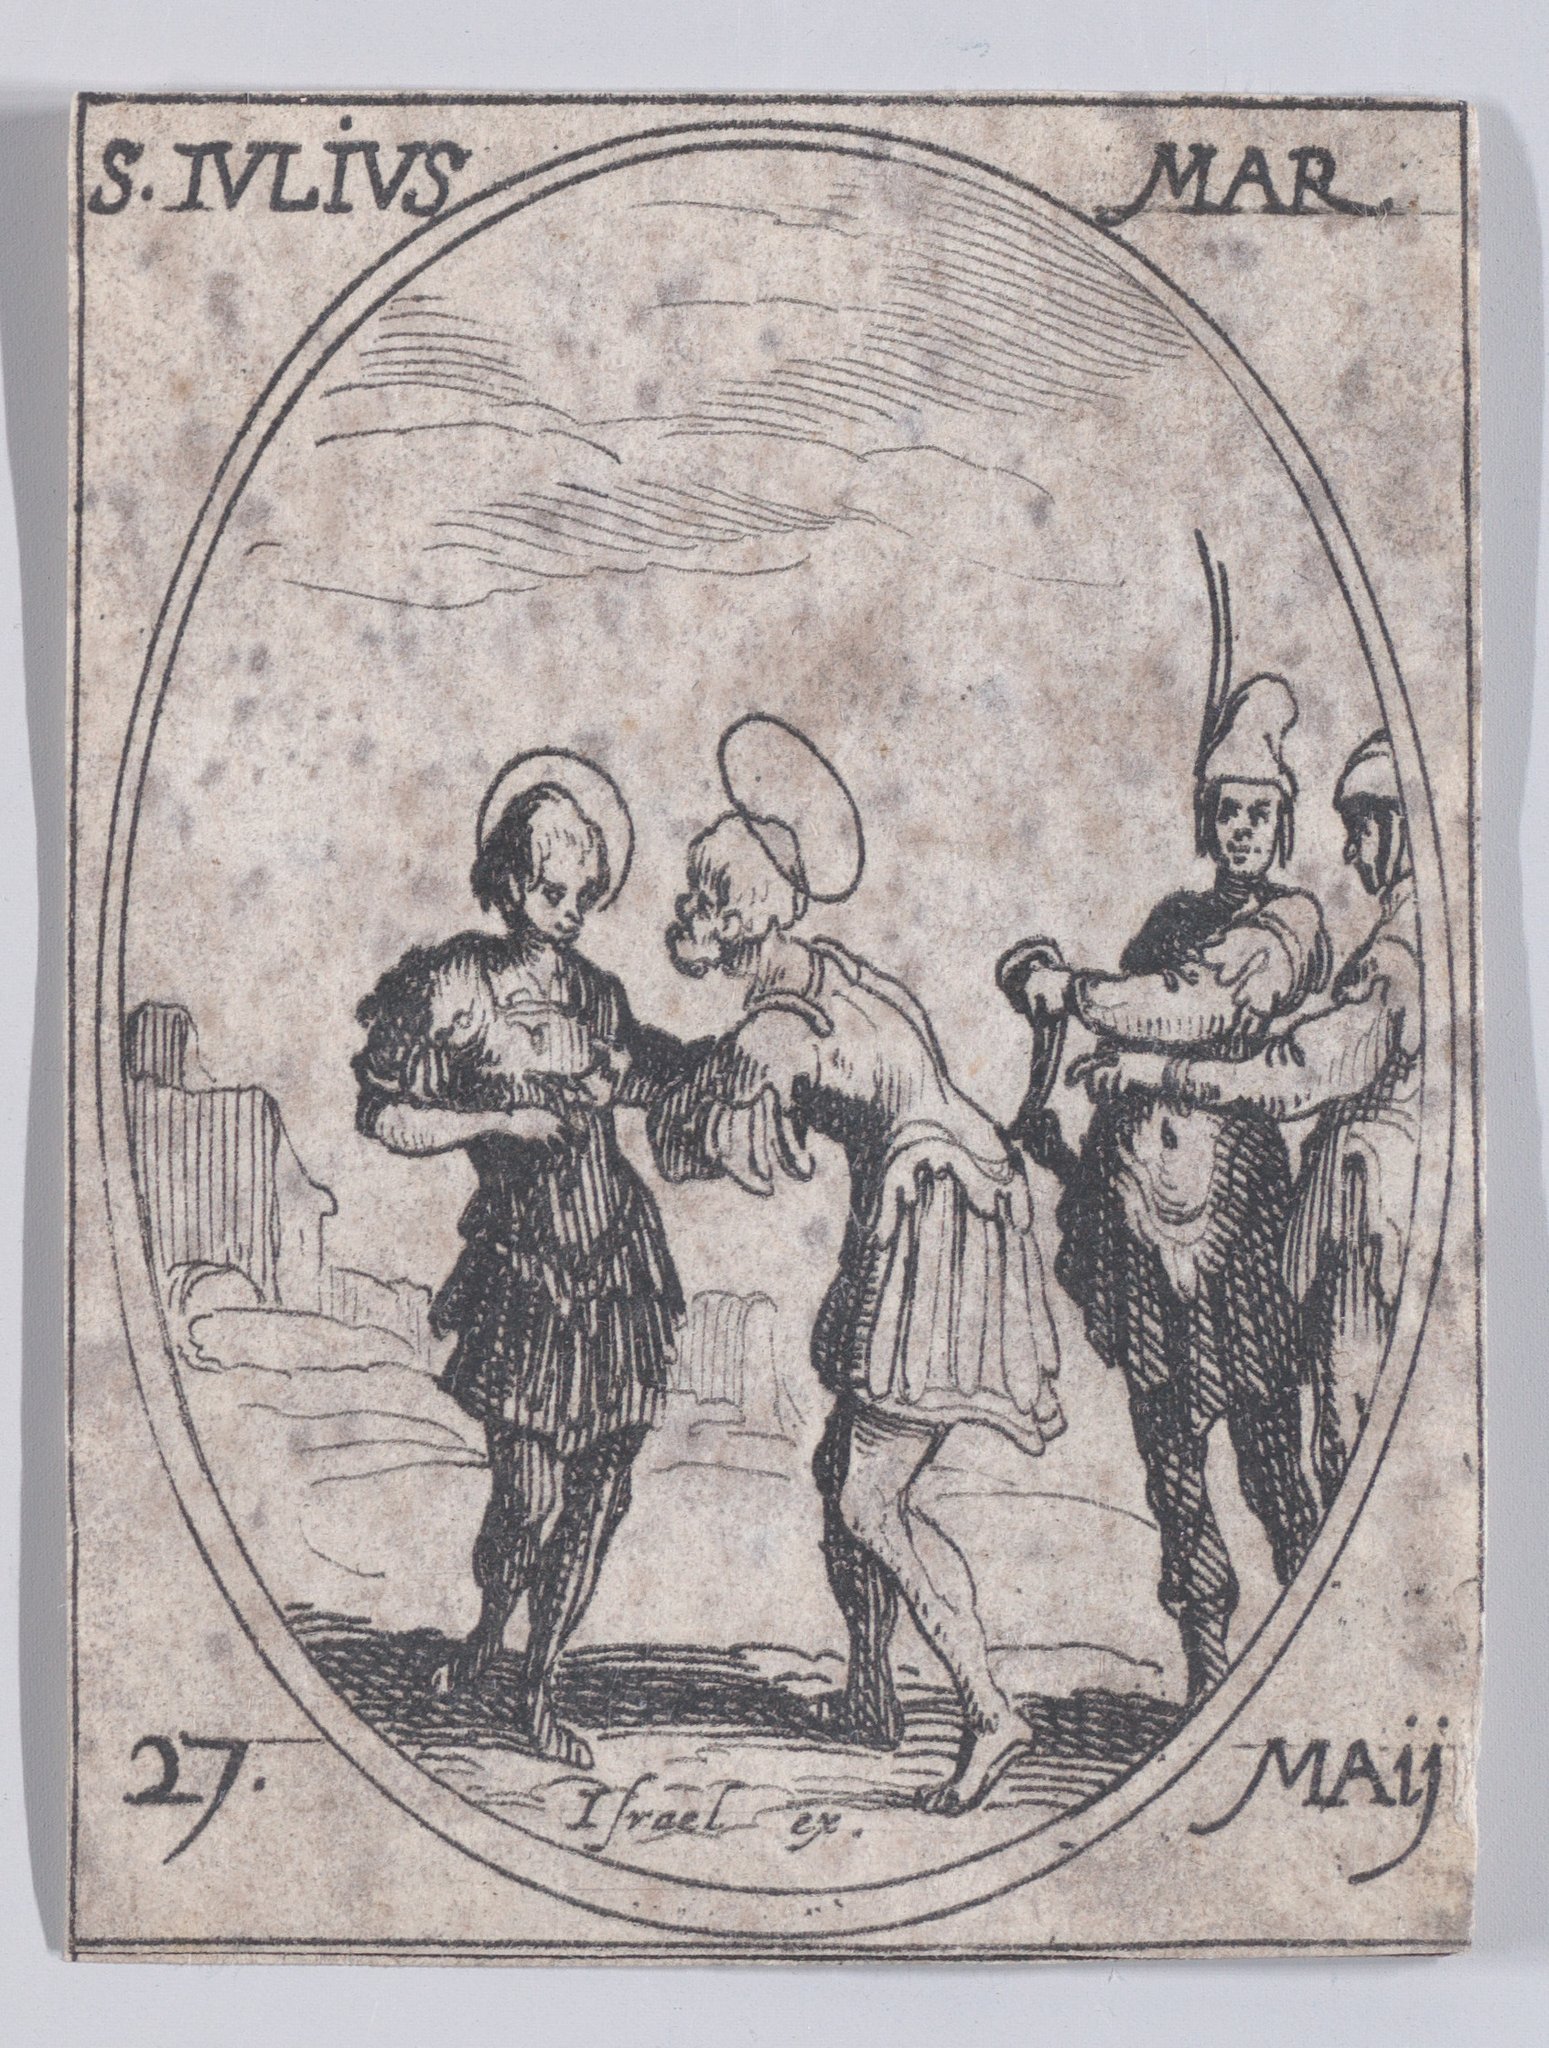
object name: print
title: St. Jules, martyr (St. Julius, Martyr), May 27th, from "Les Images De Tous Les Saincts et Saintes de L'Année" (Images of All of the Saints and Religious Events of the Year)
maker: jacques callot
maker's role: artist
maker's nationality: french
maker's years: 1592-1635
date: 1636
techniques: etching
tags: men,saints